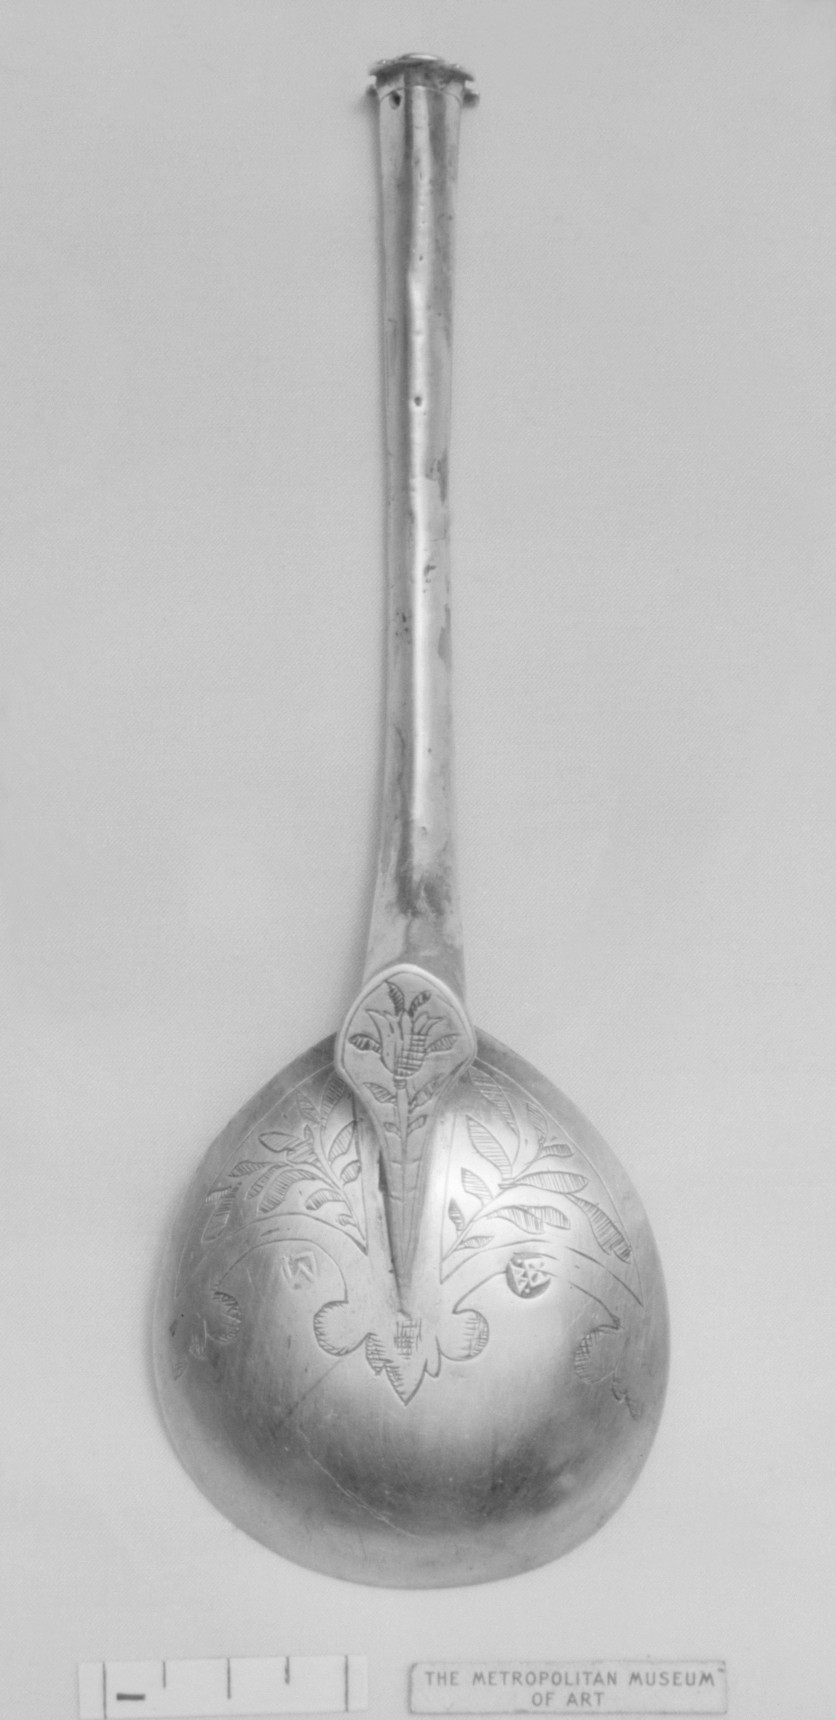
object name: medicine spoon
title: Medicine spoon (?)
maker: michael lamb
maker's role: maker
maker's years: 1575-1635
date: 1601-1700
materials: silver